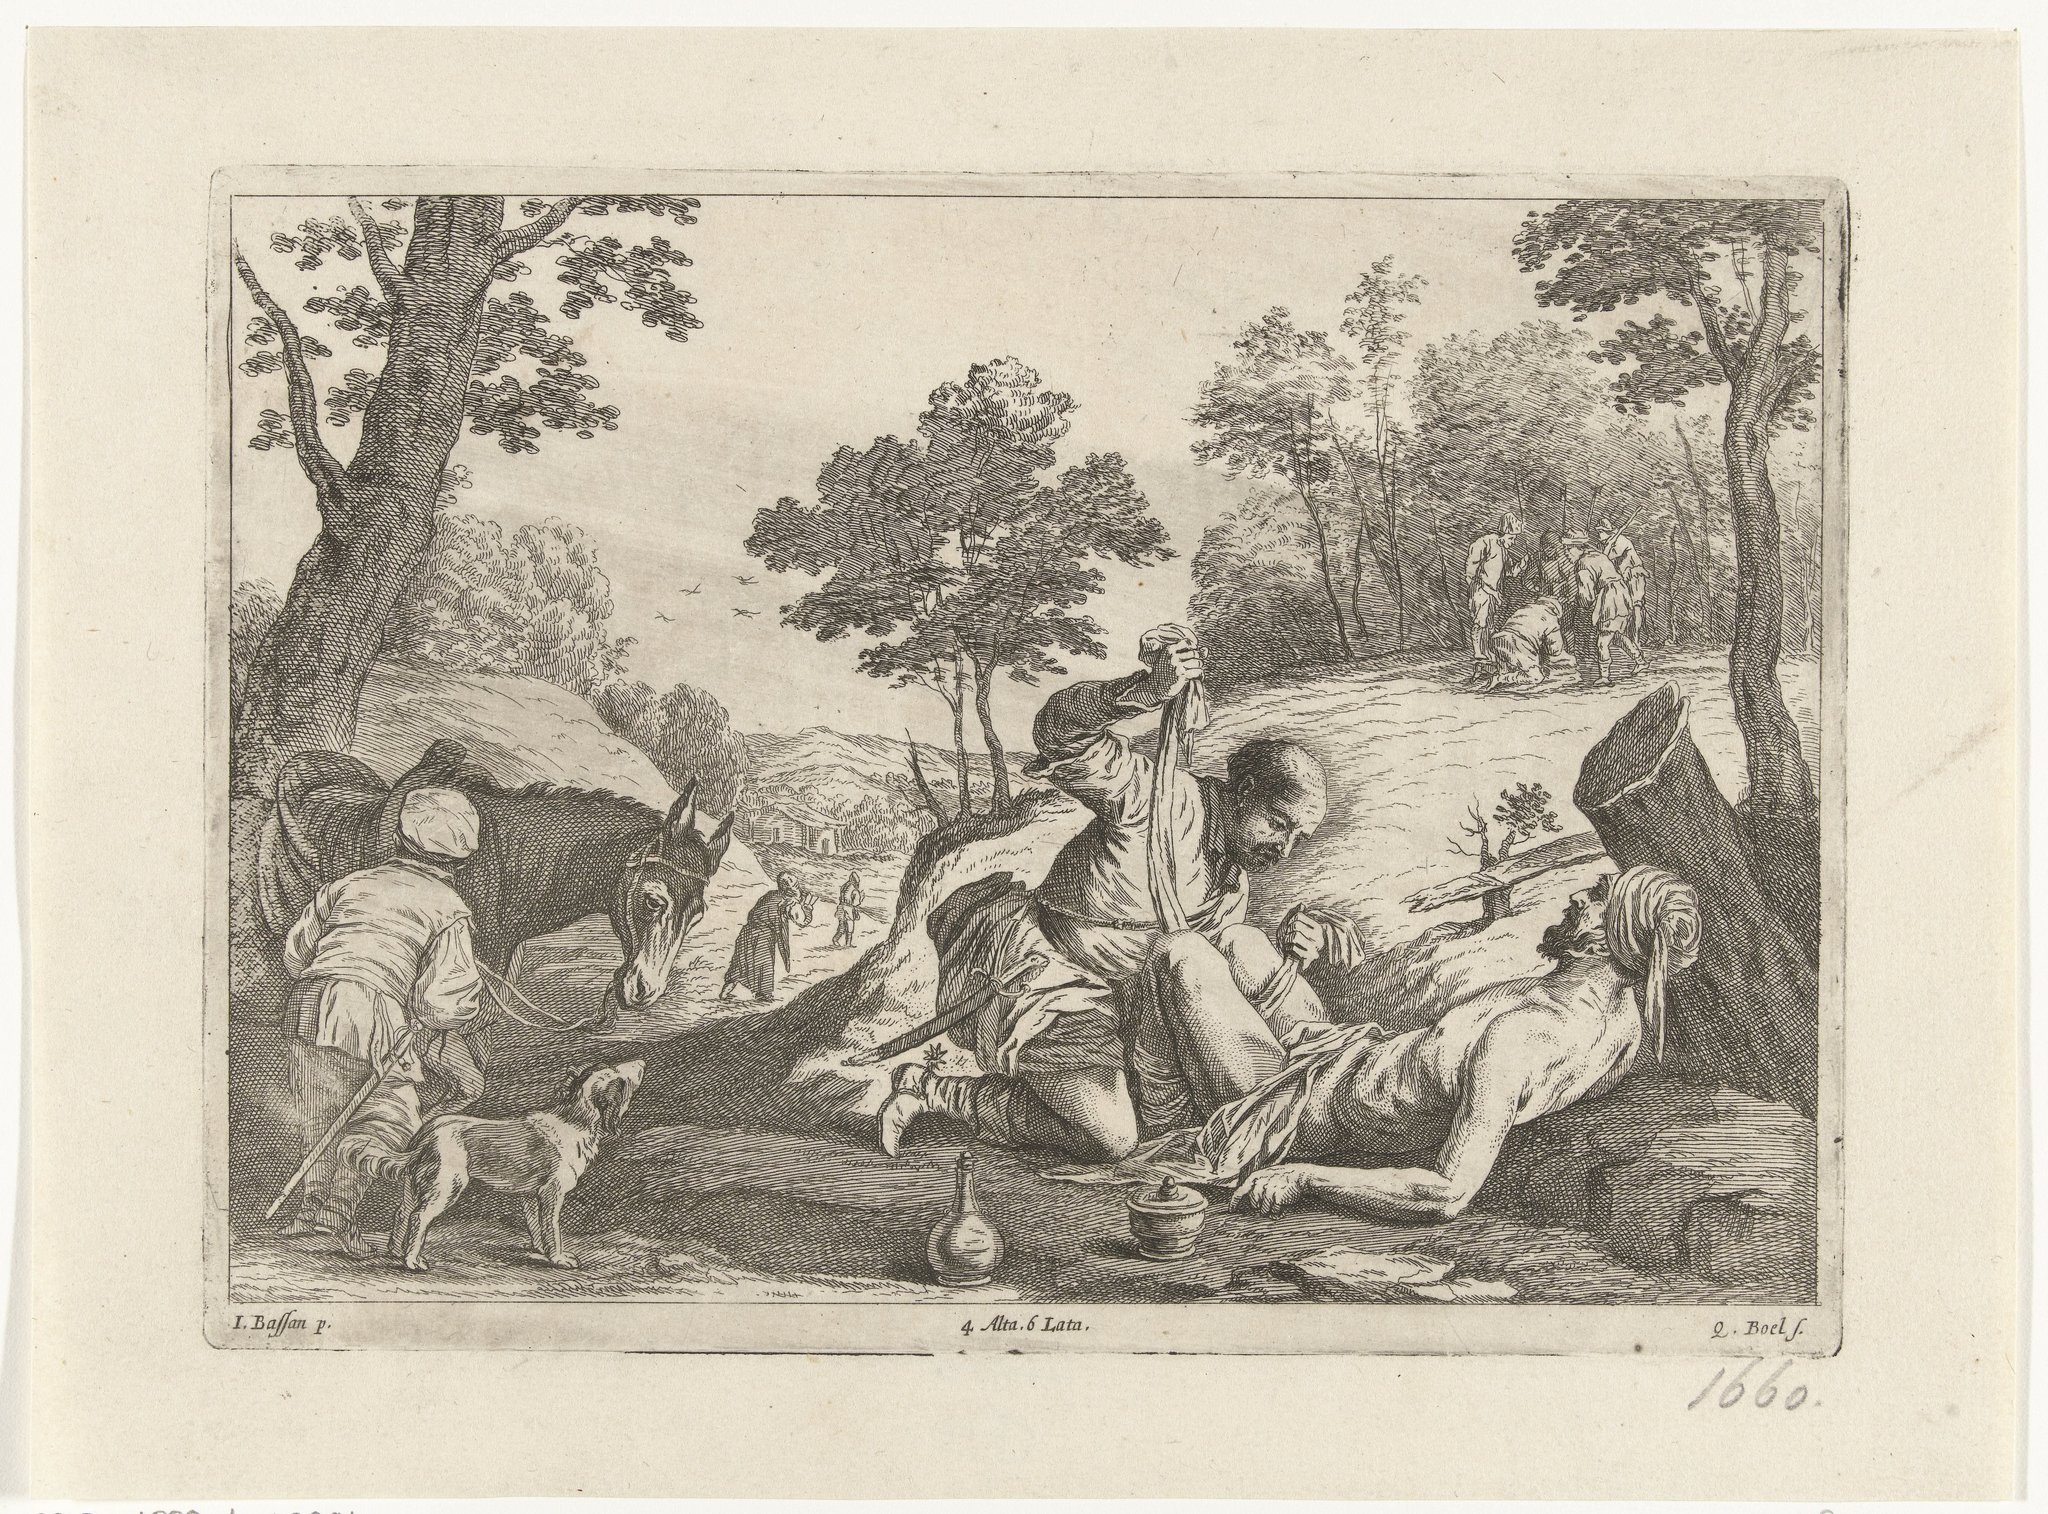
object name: print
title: De barmhartige Samaritaan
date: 1660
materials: paper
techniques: etching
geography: southern netherlands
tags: the good samaritan (luke 10:30-37)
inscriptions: collector's mark: Lugt 2228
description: De barmhartige Samaritaan giet olie op de wonden van de door struikrovers overvallen man en legt een verband aan. In de verte maken de priester en de leviet zich uit te voeten. Rechts op een heuvel is te zien hoe de reiziger overvallen werd door de struikrovers. Prent uit de catalogus van Italiaanse schilderijen van Leopold Willem, landvoogd der Zuidelijke Nederlanden, Theatrum Pictorum samengesteld door David Terniers; in de ondermarge staan de afmetingen van het originele schilderij.